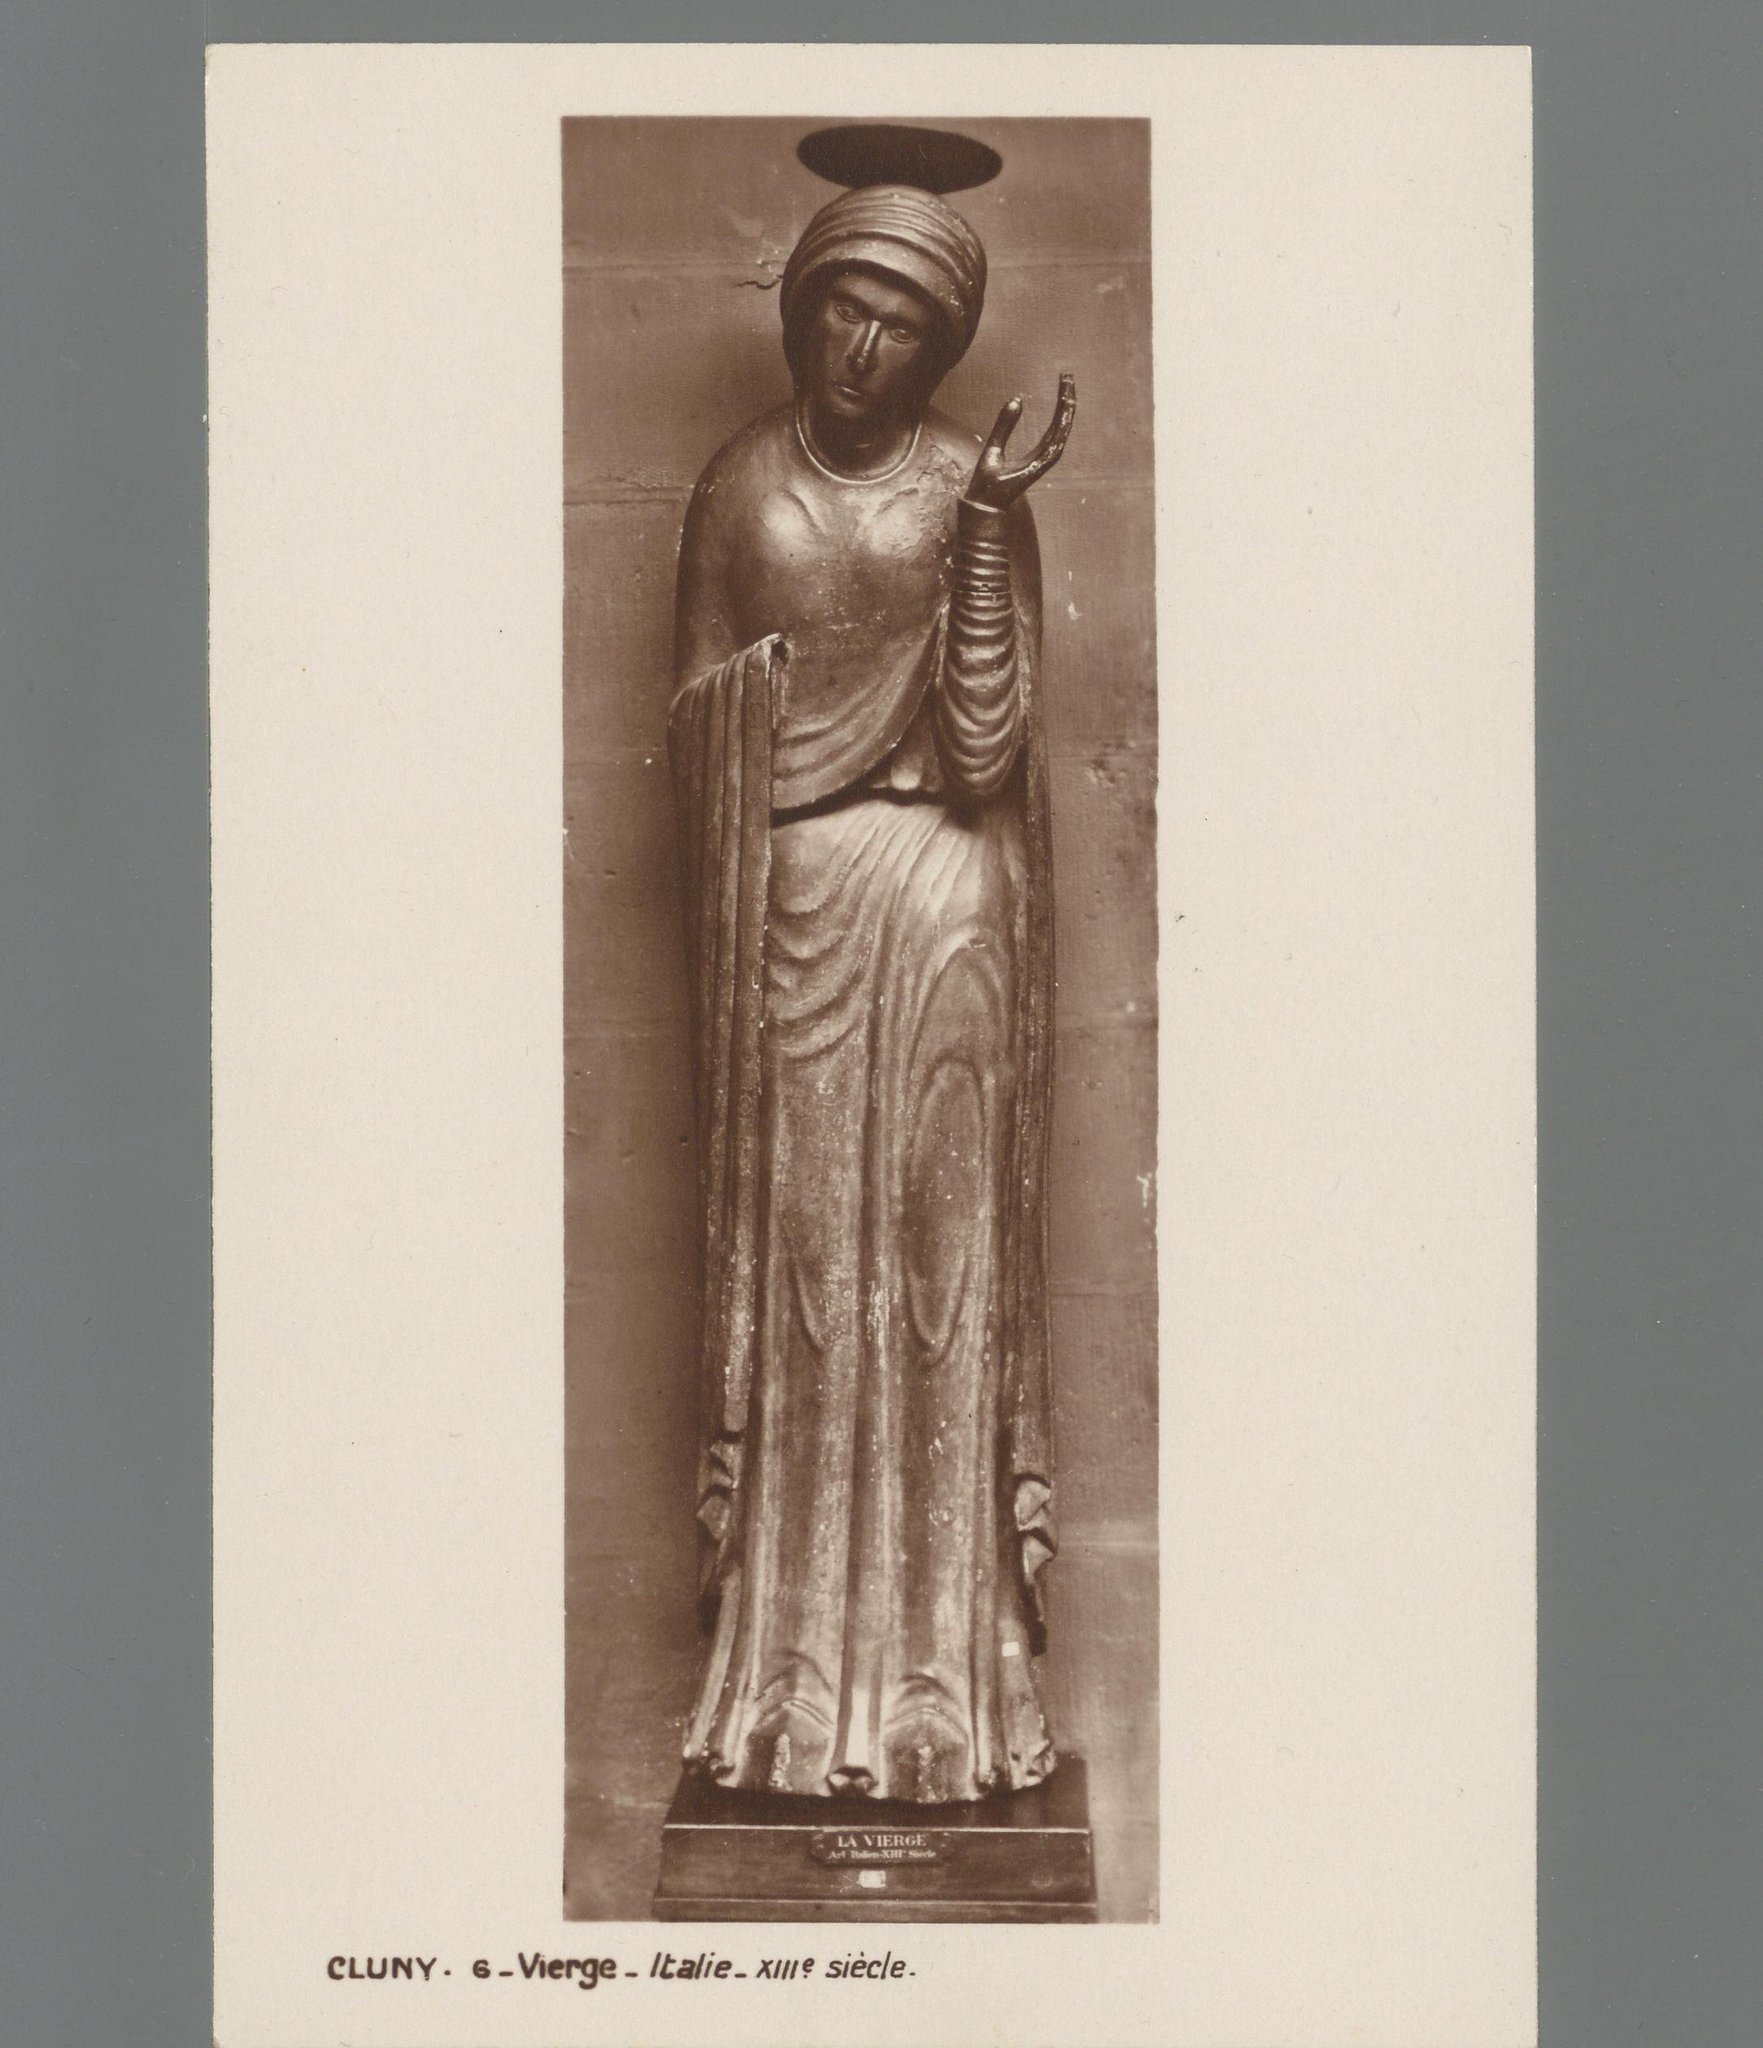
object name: ansichtkaart, prentbriefkaart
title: Cluny. Vierge. Italie XIIIe siècle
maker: Anonymous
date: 1903-1930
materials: paper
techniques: gelatin silver print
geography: cluny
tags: statues, paintings, etc. ~ objects of worship in roman religion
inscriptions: collector's mark: ‘AFE v S’